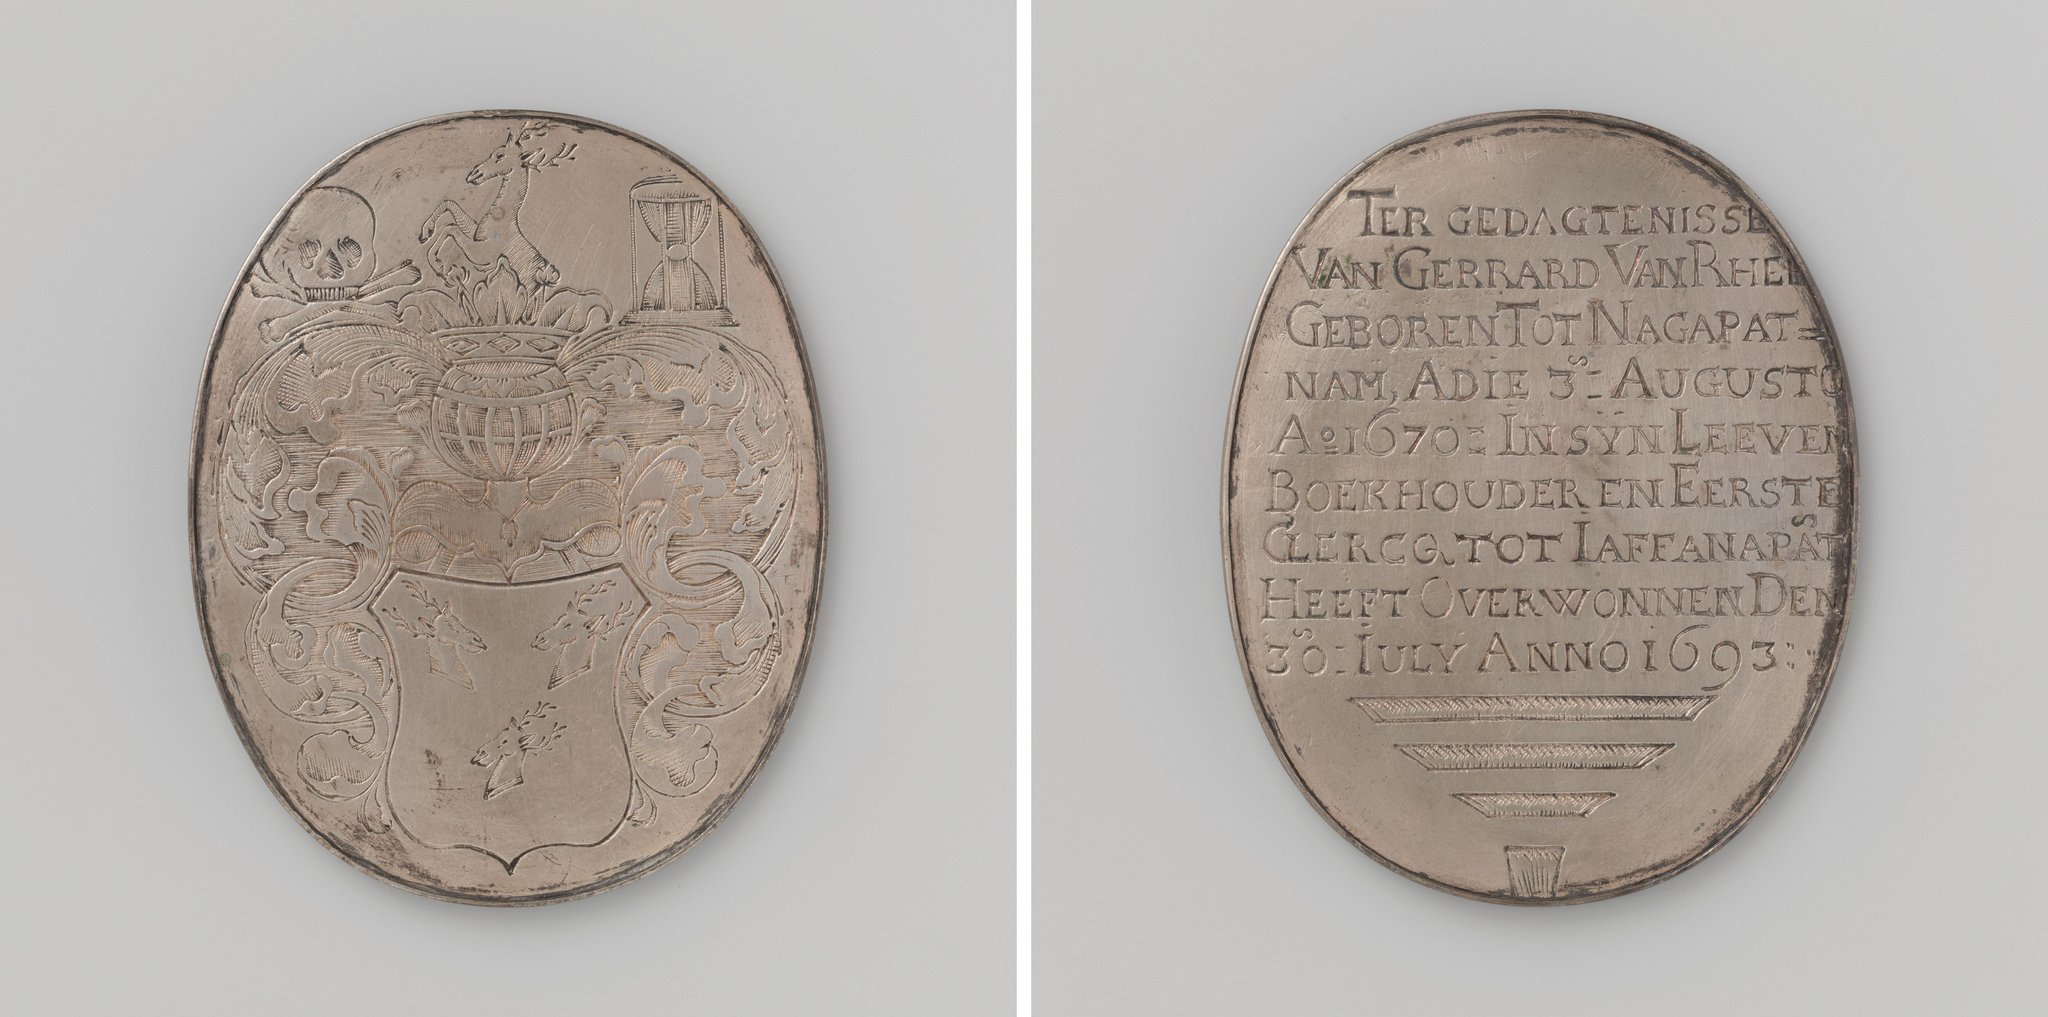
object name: family medal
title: Overlijden van Gerard van Rhee, boekhouder en eerste klerk te Jaffnapatnam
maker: Anonymous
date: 1693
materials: metal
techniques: engraving, silvering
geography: sri lanka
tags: gerard van rhee, jaffnapatnam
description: ovale penning. Voorzijde: gehelmd wapenschild bekroond met ree tussen doodshoofd en zandloper. Keerzijde: opschrift